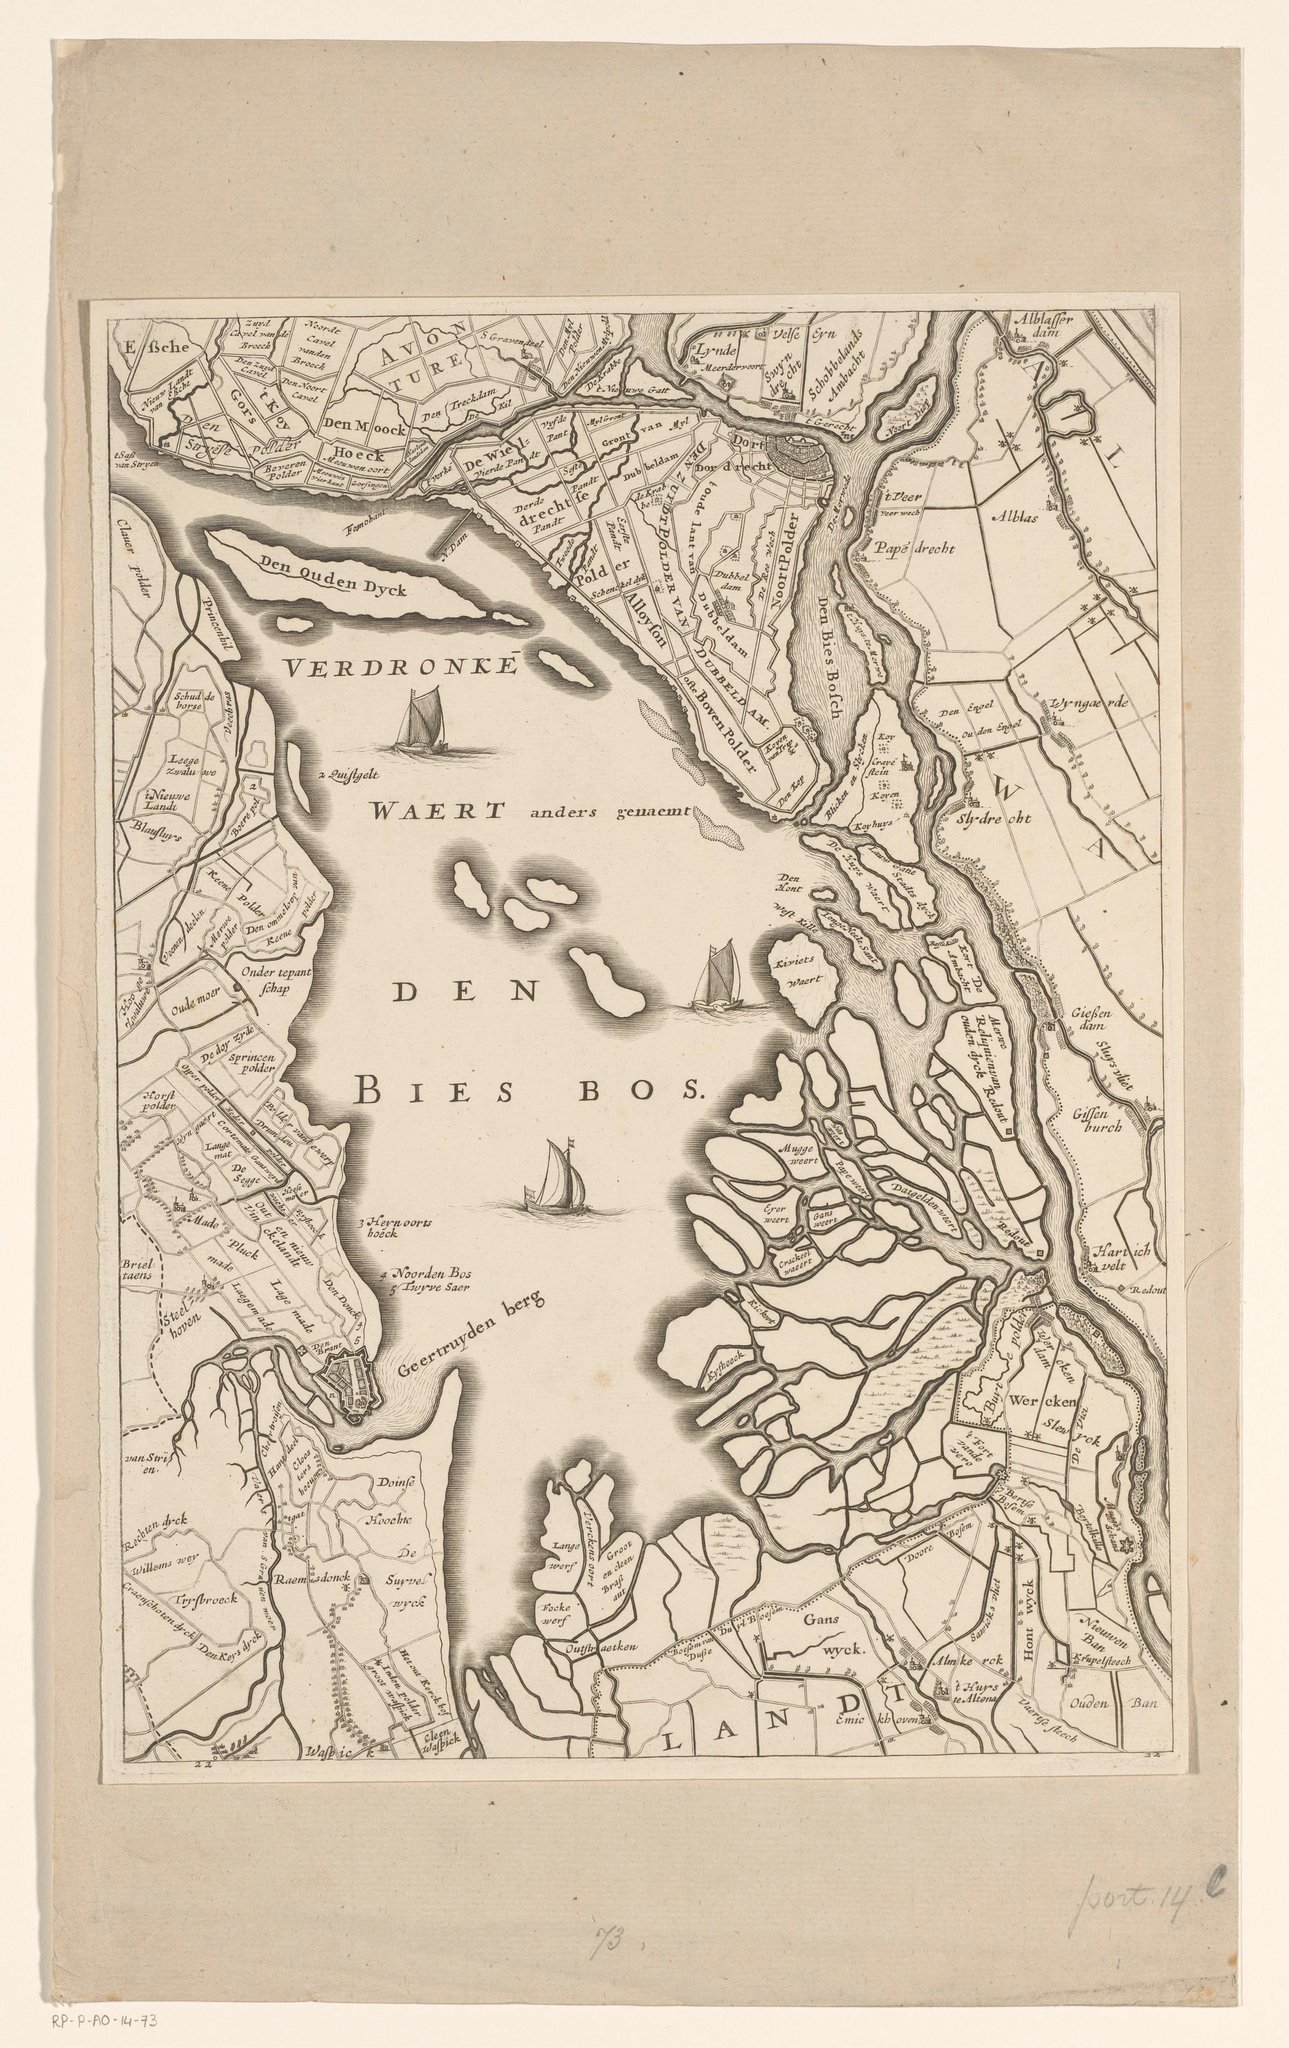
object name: map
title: Kaart van het gebied rond de verdronken Zuid-Hollandse Waard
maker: Anonymous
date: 1650-1749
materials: paper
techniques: engraving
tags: maps of separate countries or regions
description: Kaart van het gebied rond de verdronken Zuid-Hollandse Waard – ook wel de Biesbos genoemd – ontstaan na de Sint-Elisabethsvloed van 1421. Oriëntatie: noorden rechts. Links- en rechtsonder genummerd: 22.